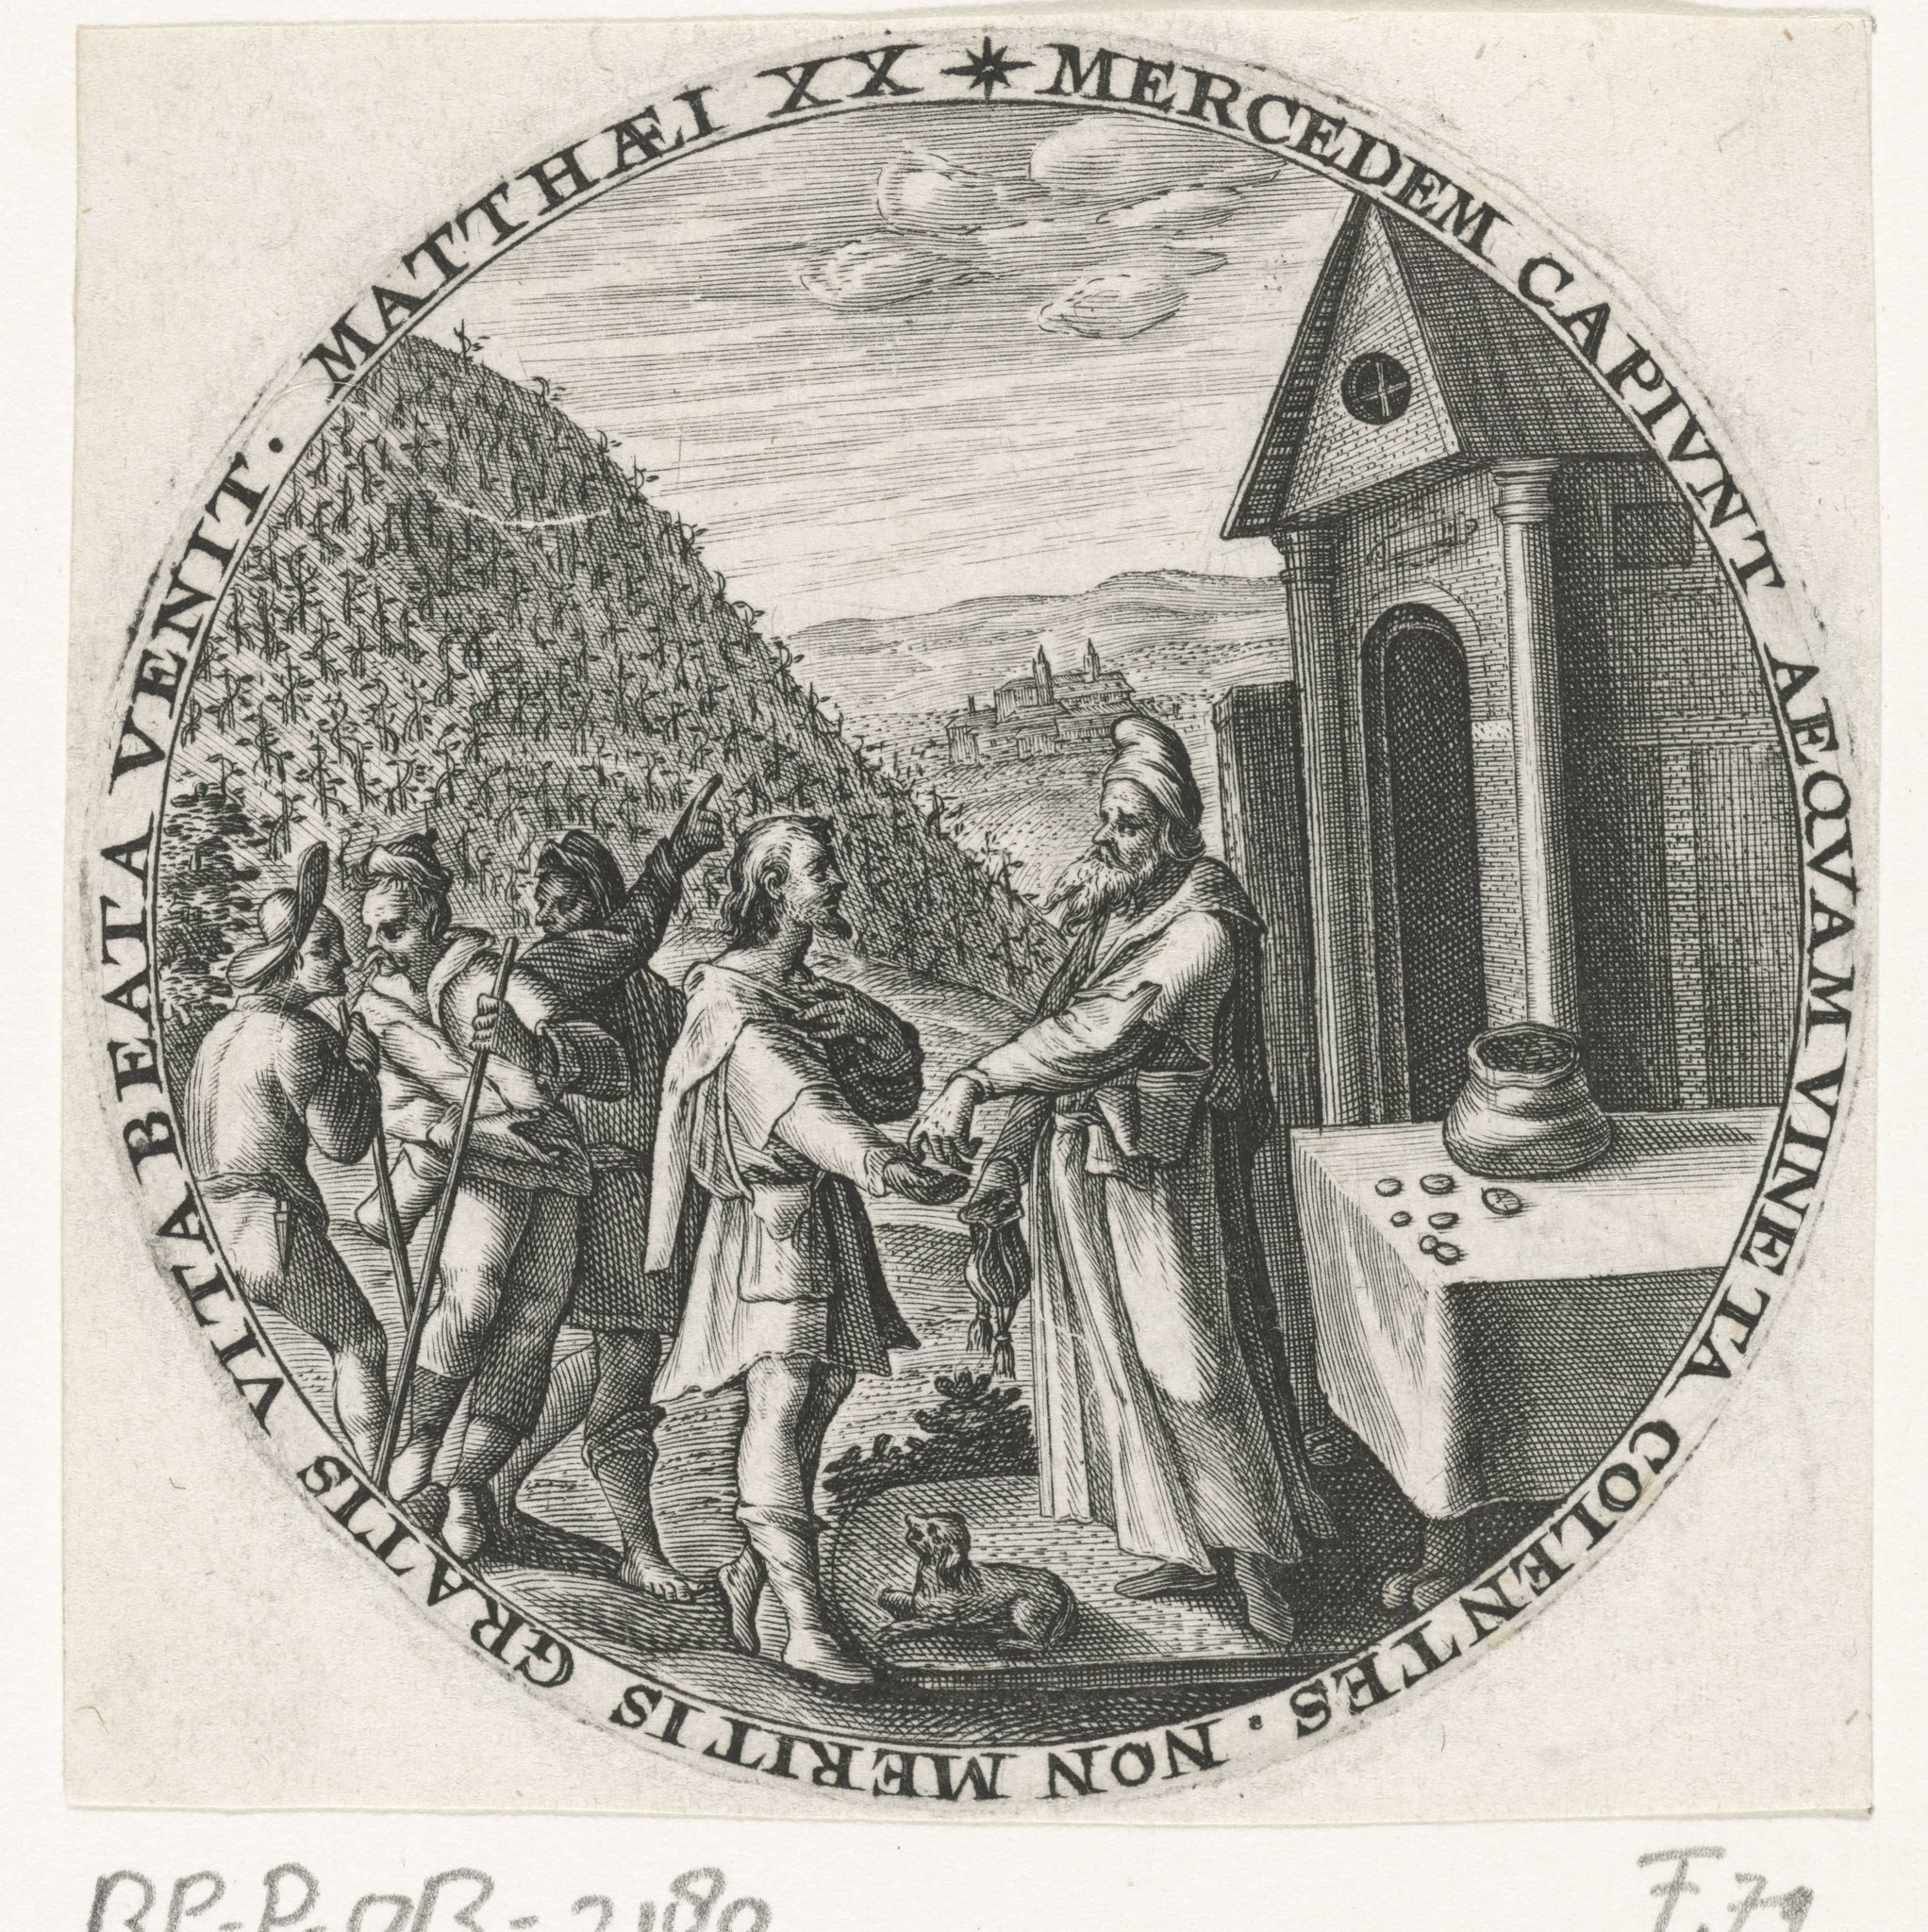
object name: print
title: Parabolarum Evagelicaru Typi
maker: crispijn van de passe (i)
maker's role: draughtsman, print maker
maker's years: 1564-1637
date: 1604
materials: paper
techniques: engraving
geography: cologne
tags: the labourers in the vineyard ~ parable of christ (matthew 20:1-16)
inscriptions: collector's mark: Lugt 240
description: De arbeiders ontvangen na hun werk in de wijngaard het loon van één denarie van de rentmeester van de landheer (Mat. 20). De voorstelling is gevat in een ronde omlijsting met een randschrift in het Latijn. Prent uit een serie met gelijkenissen van Christus.